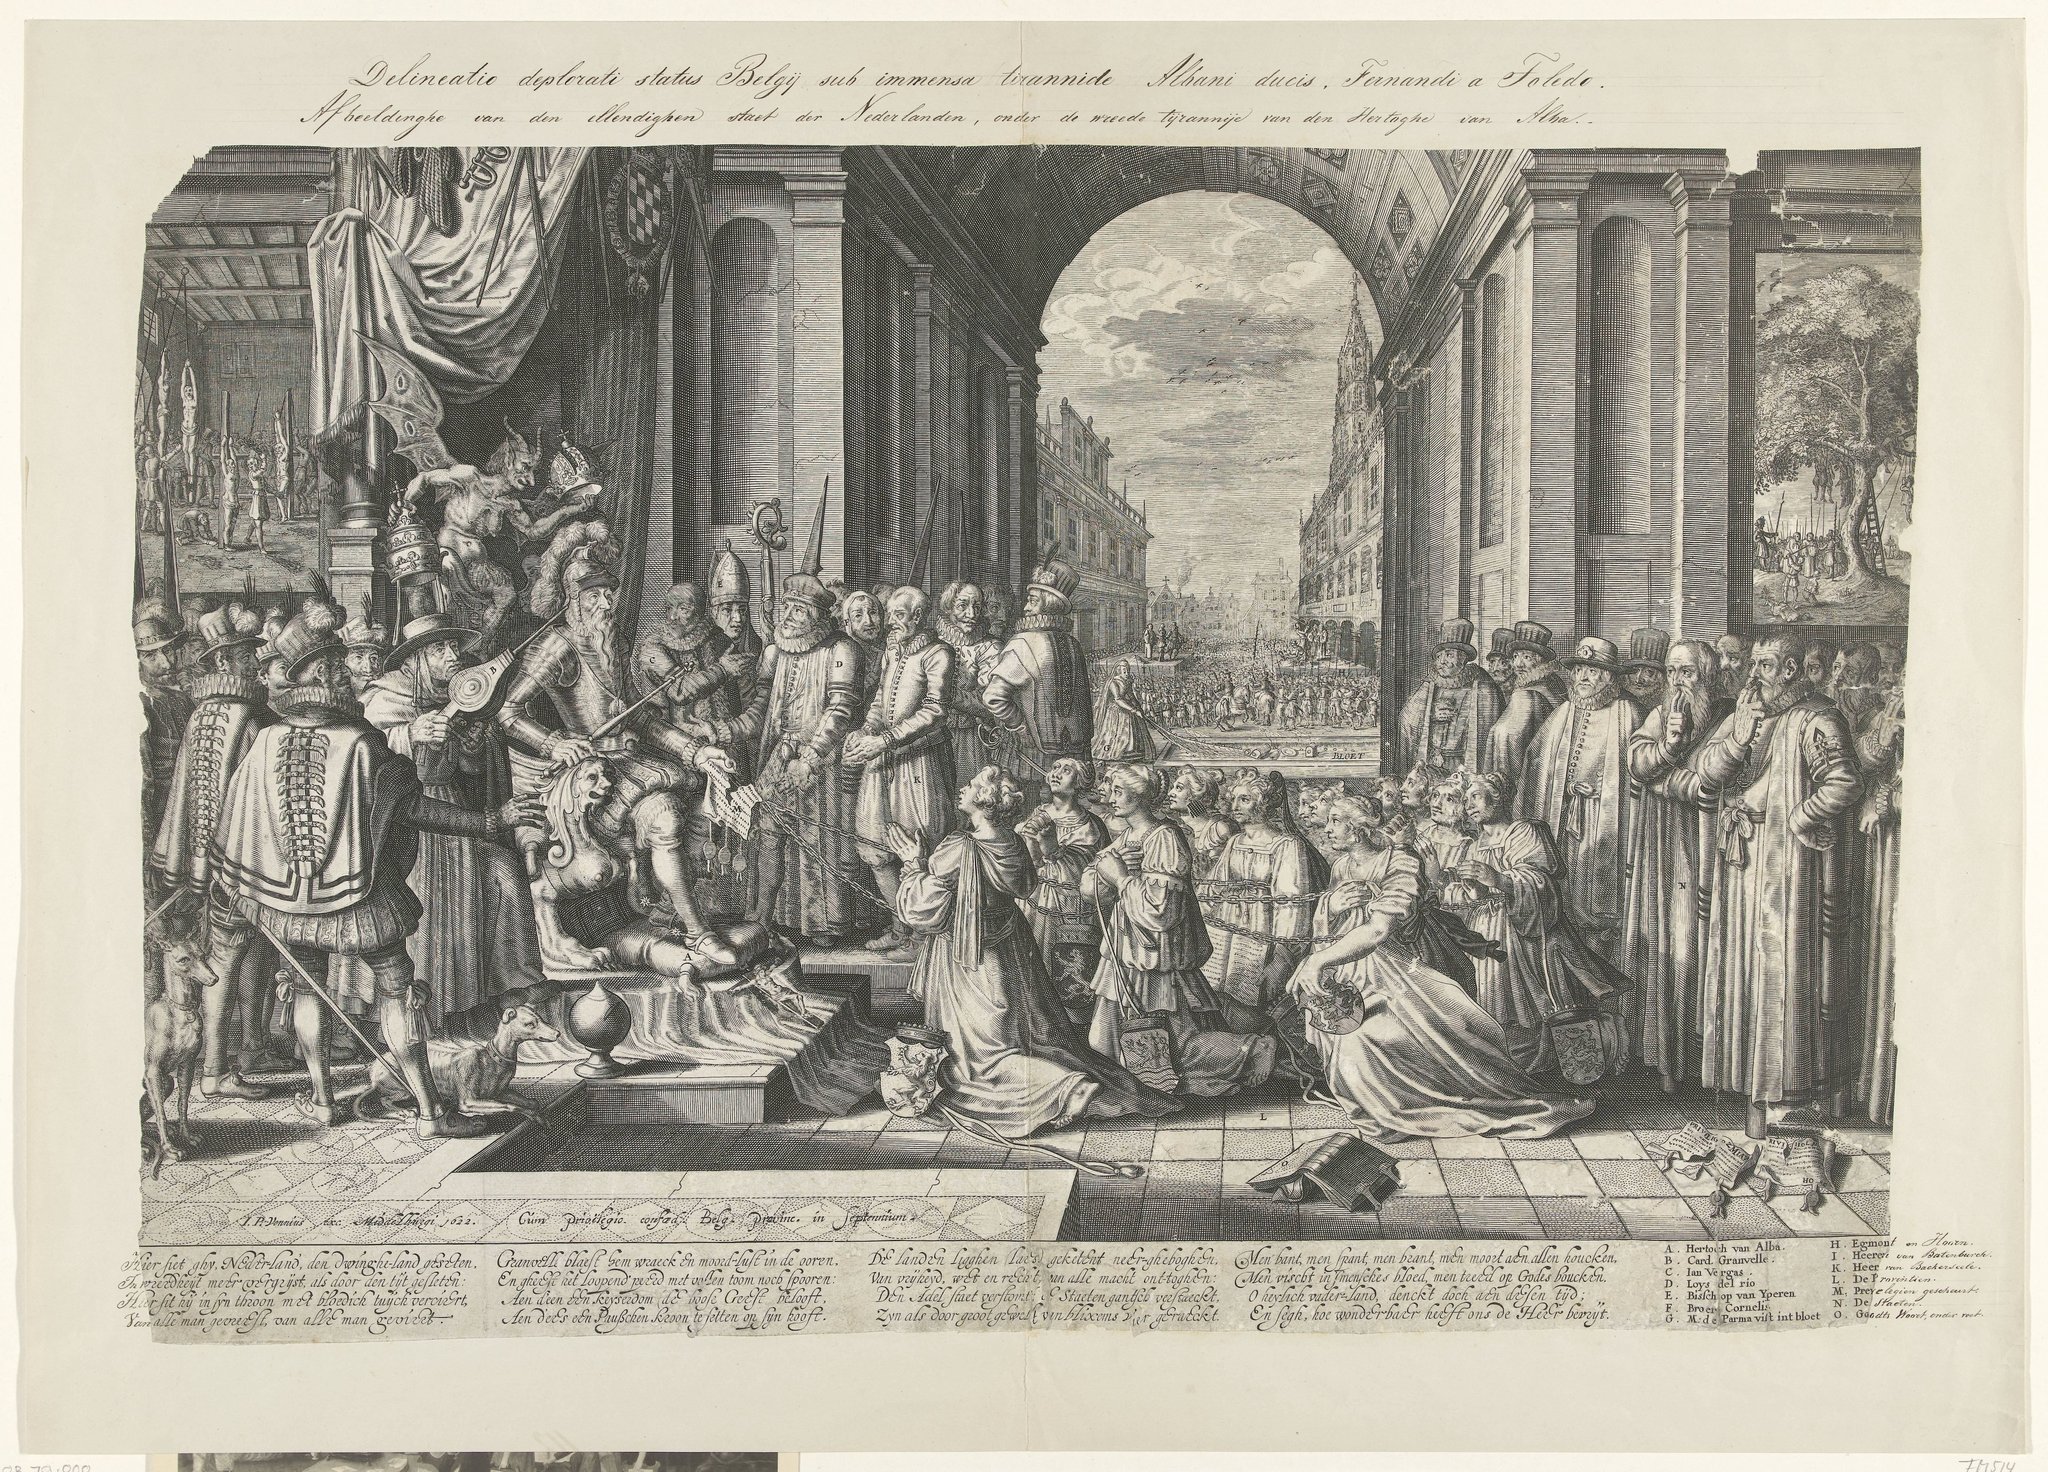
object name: history print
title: Delineatio deplorati status Belgy sub immensa tirannide Albani ducis, Ferdinandi a Toledo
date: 1622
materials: paper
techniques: engraving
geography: middelburg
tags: fernando álvarez de toledo (3rd duke of alba), antoine perrenot de granvelle, brussels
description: Allegorie op de tirannie van de hertog van Alva in de Nederlanden, ca. 1569. Links Alva op zijn troon in een paleis, bijgestaan door Granvelle (met blaasbalg) en leden van de Bloedraad, hij wordt door de duivel gekroond. Voor hem knielen geketend de 17 personificaties van de provincies van de Nederlanden, rechts de verstomde leden van de Staten-Generaal. Een venster in het midden geeft zicht op Margaretha van Parma die vist naar rijkdommen in een bloedvijver, daarachter de onthoofding van Egmond en Horne te Brussel in 1568. Links en rechts scènes van martelingen en executies. In het onderschrift een vers van 4 kolommen van elk 4 regels en de legenda A-O in het Nederlands. Incompleet exemplaar zonder de titel en delen van het onderschrift.